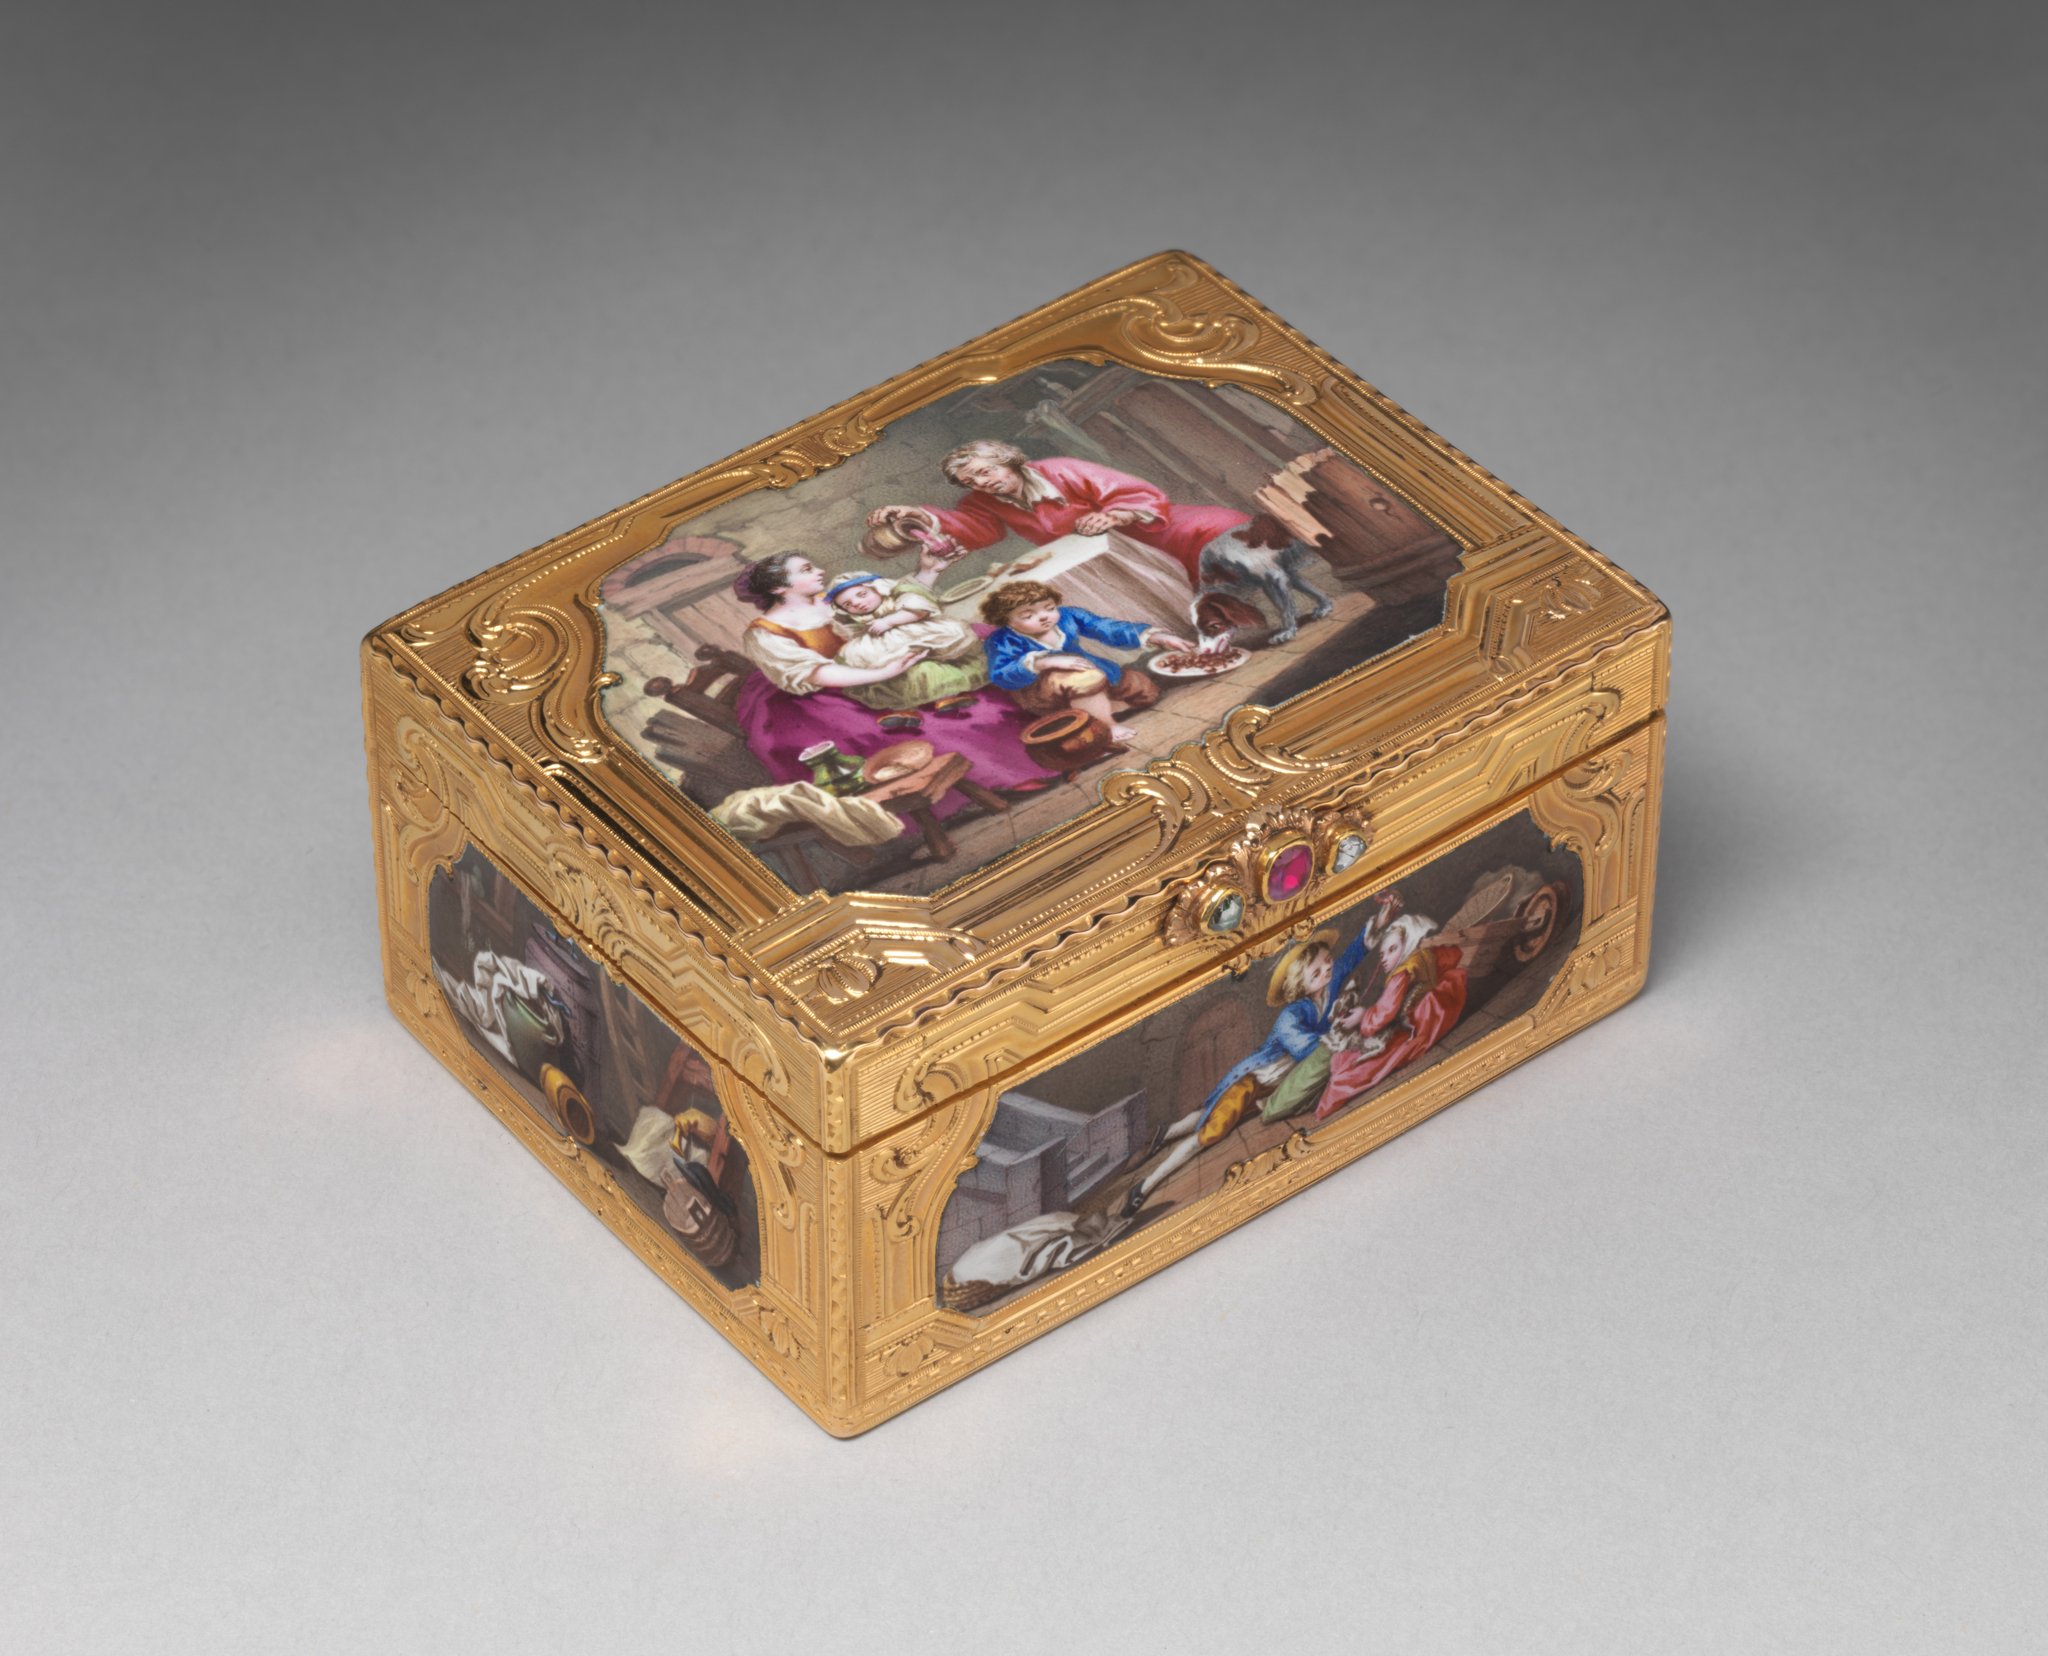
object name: snuffbox, painting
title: Snuffbox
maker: mathieu coiny fils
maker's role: maker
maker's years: 1723-1823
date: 1759-1760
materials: enamel, gold, stone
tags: children,men,women,dogs